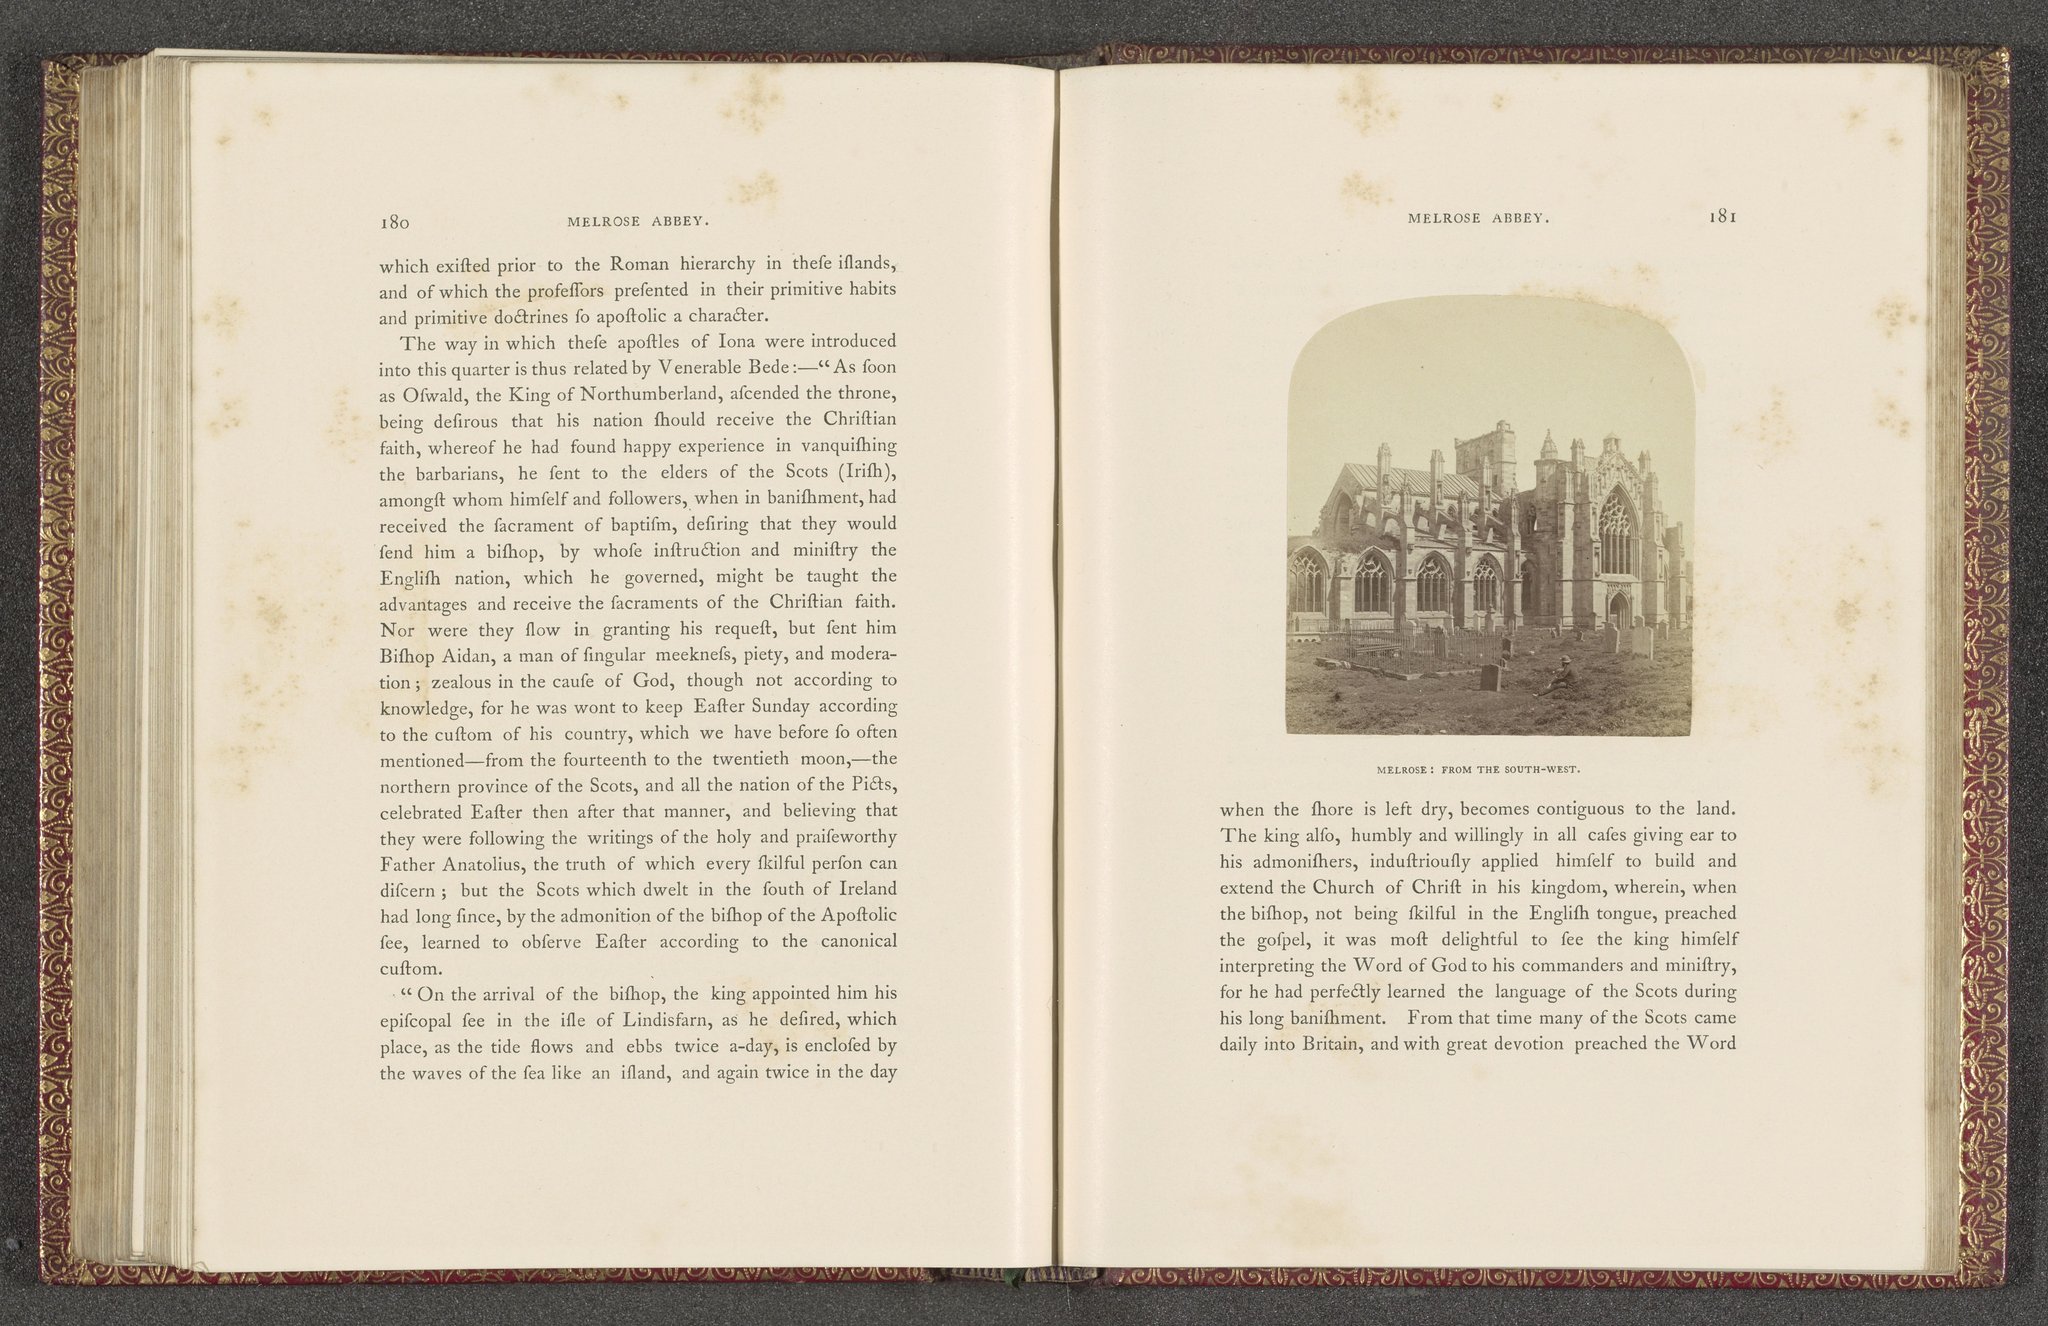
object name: page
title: Gezicht op Melrose Abbey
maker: george washington wilson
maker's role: publisher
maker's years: 1823-1893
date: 1852-1862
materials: photographic support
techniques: albumen print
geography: melrose abbey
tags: ruin of church, monastery, etc.